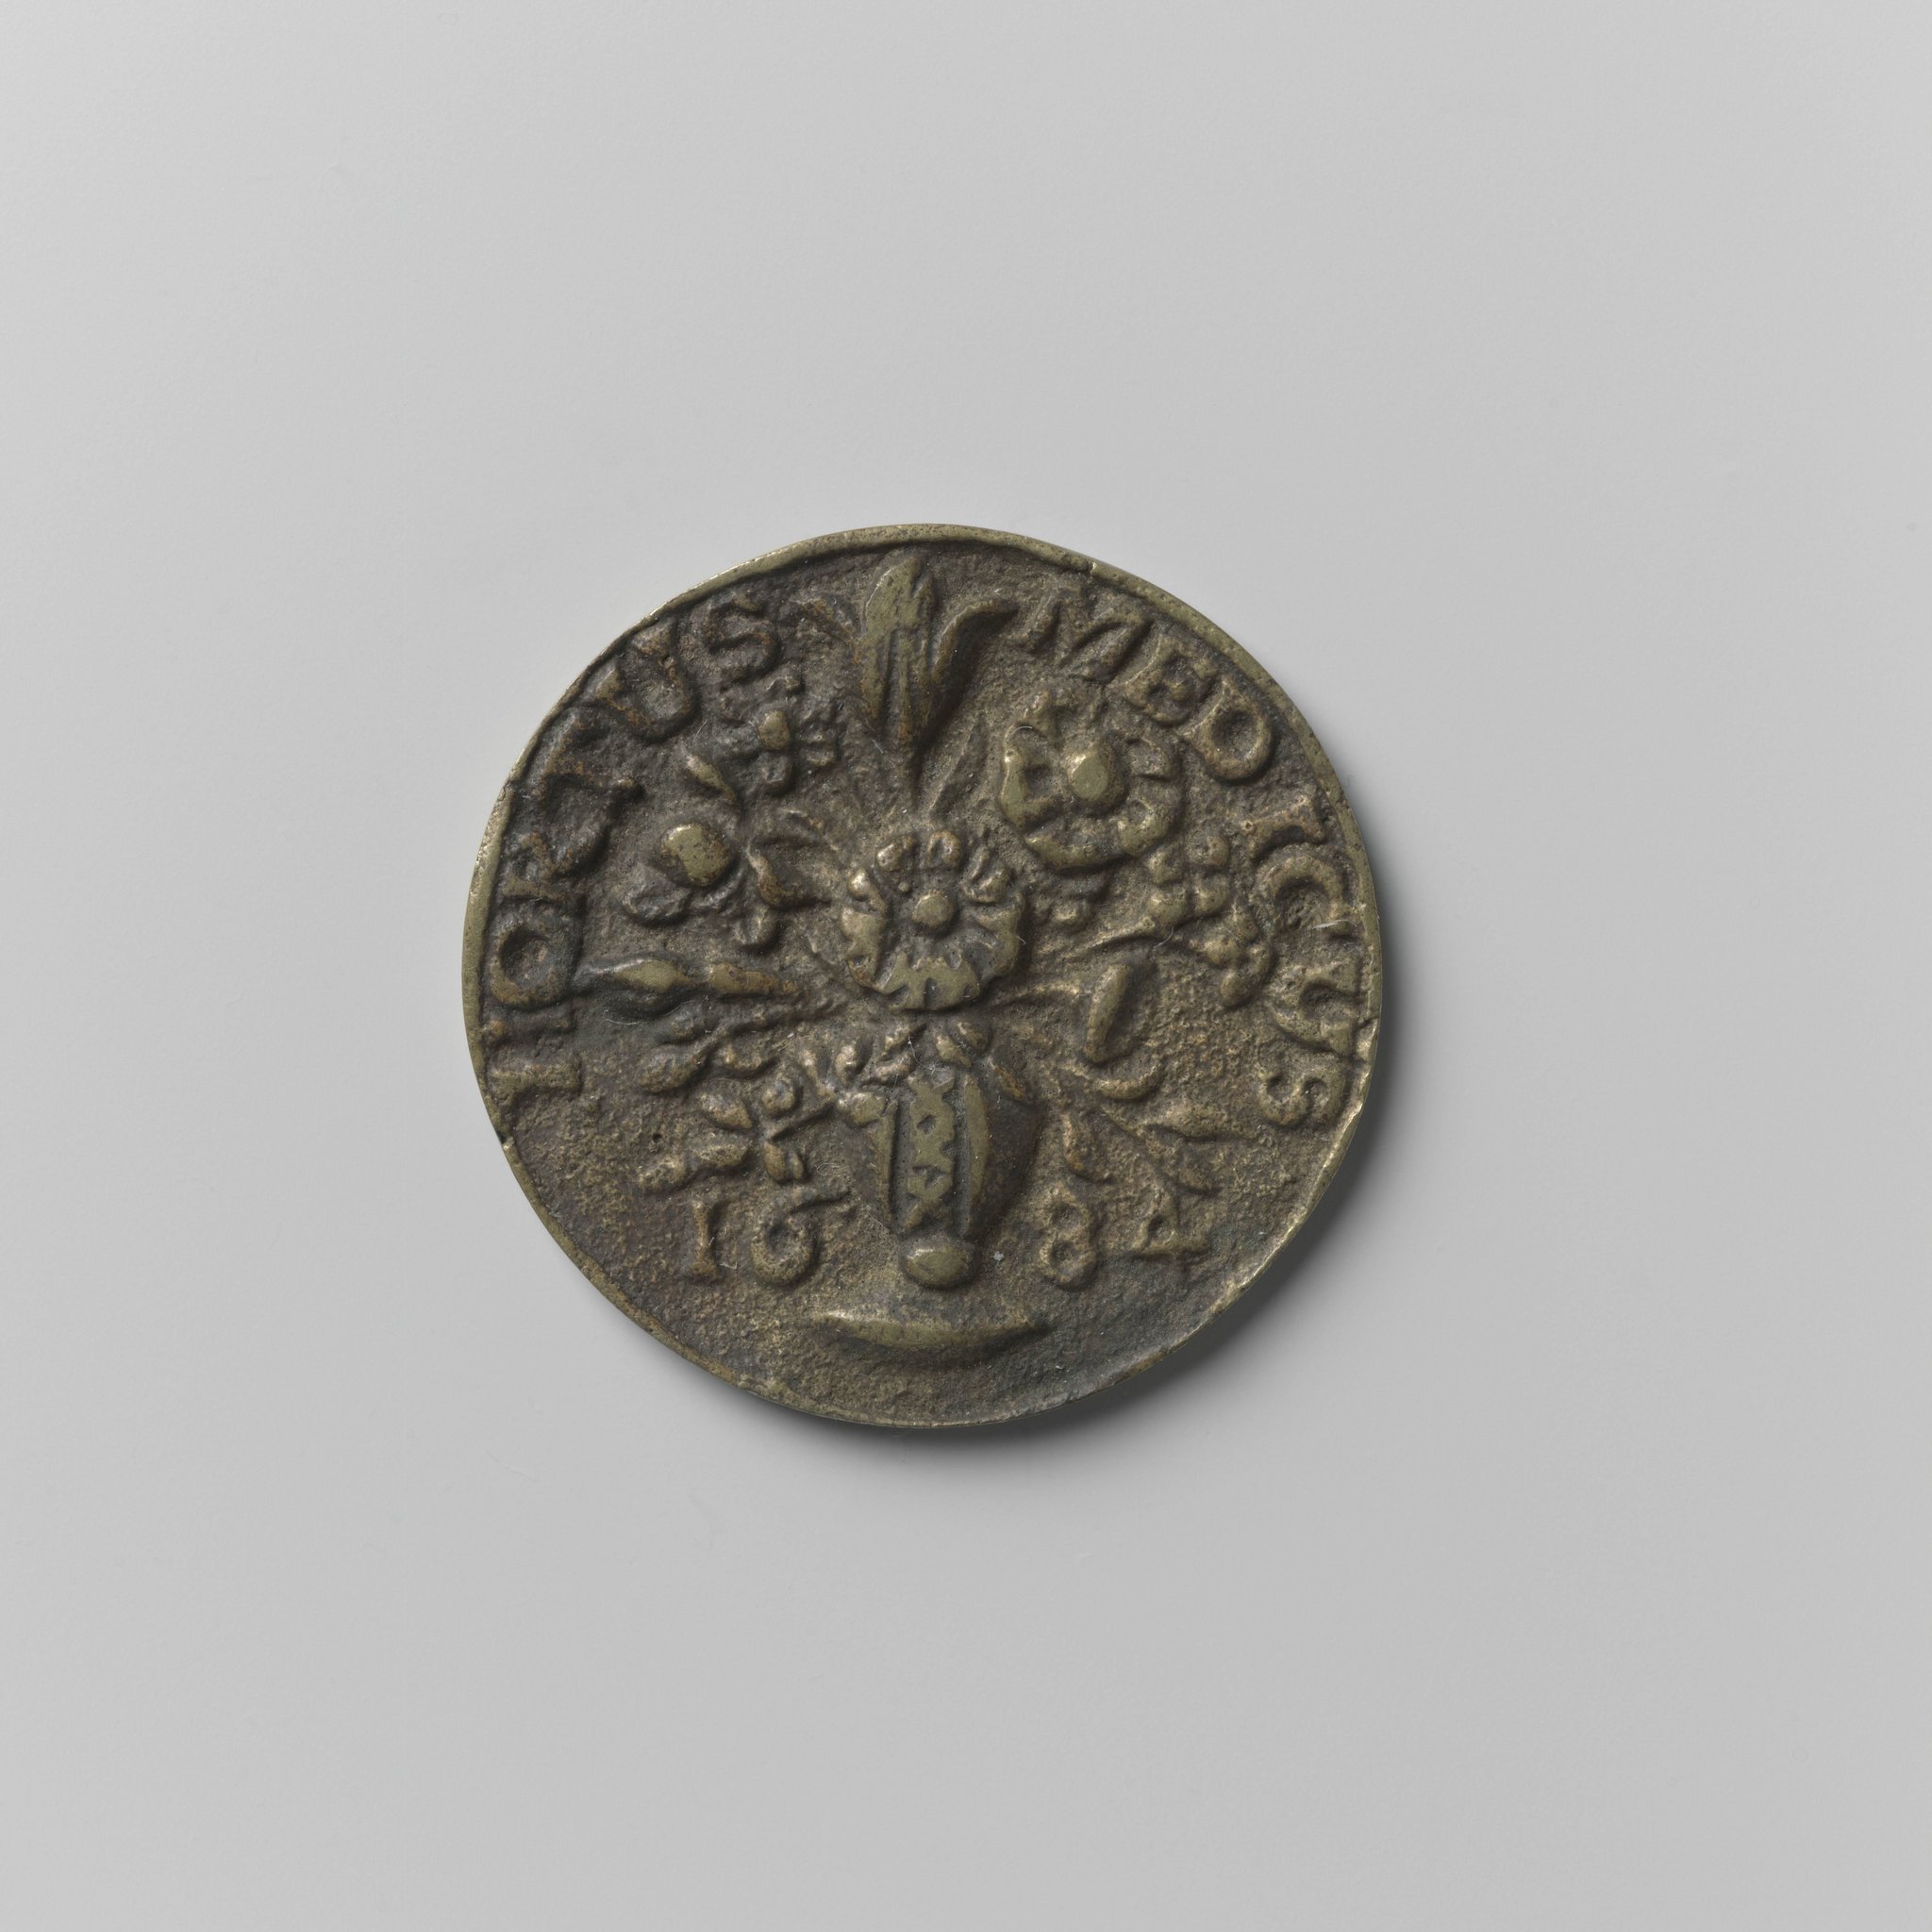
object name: toegangspenning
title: Collegium Medicum te Amsterdam, toegangspenning voor de hortus medicus voor apothekersleerlingen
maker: Anonymous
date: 1684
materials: brass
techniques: casting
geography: amsterdam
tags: amsterdam